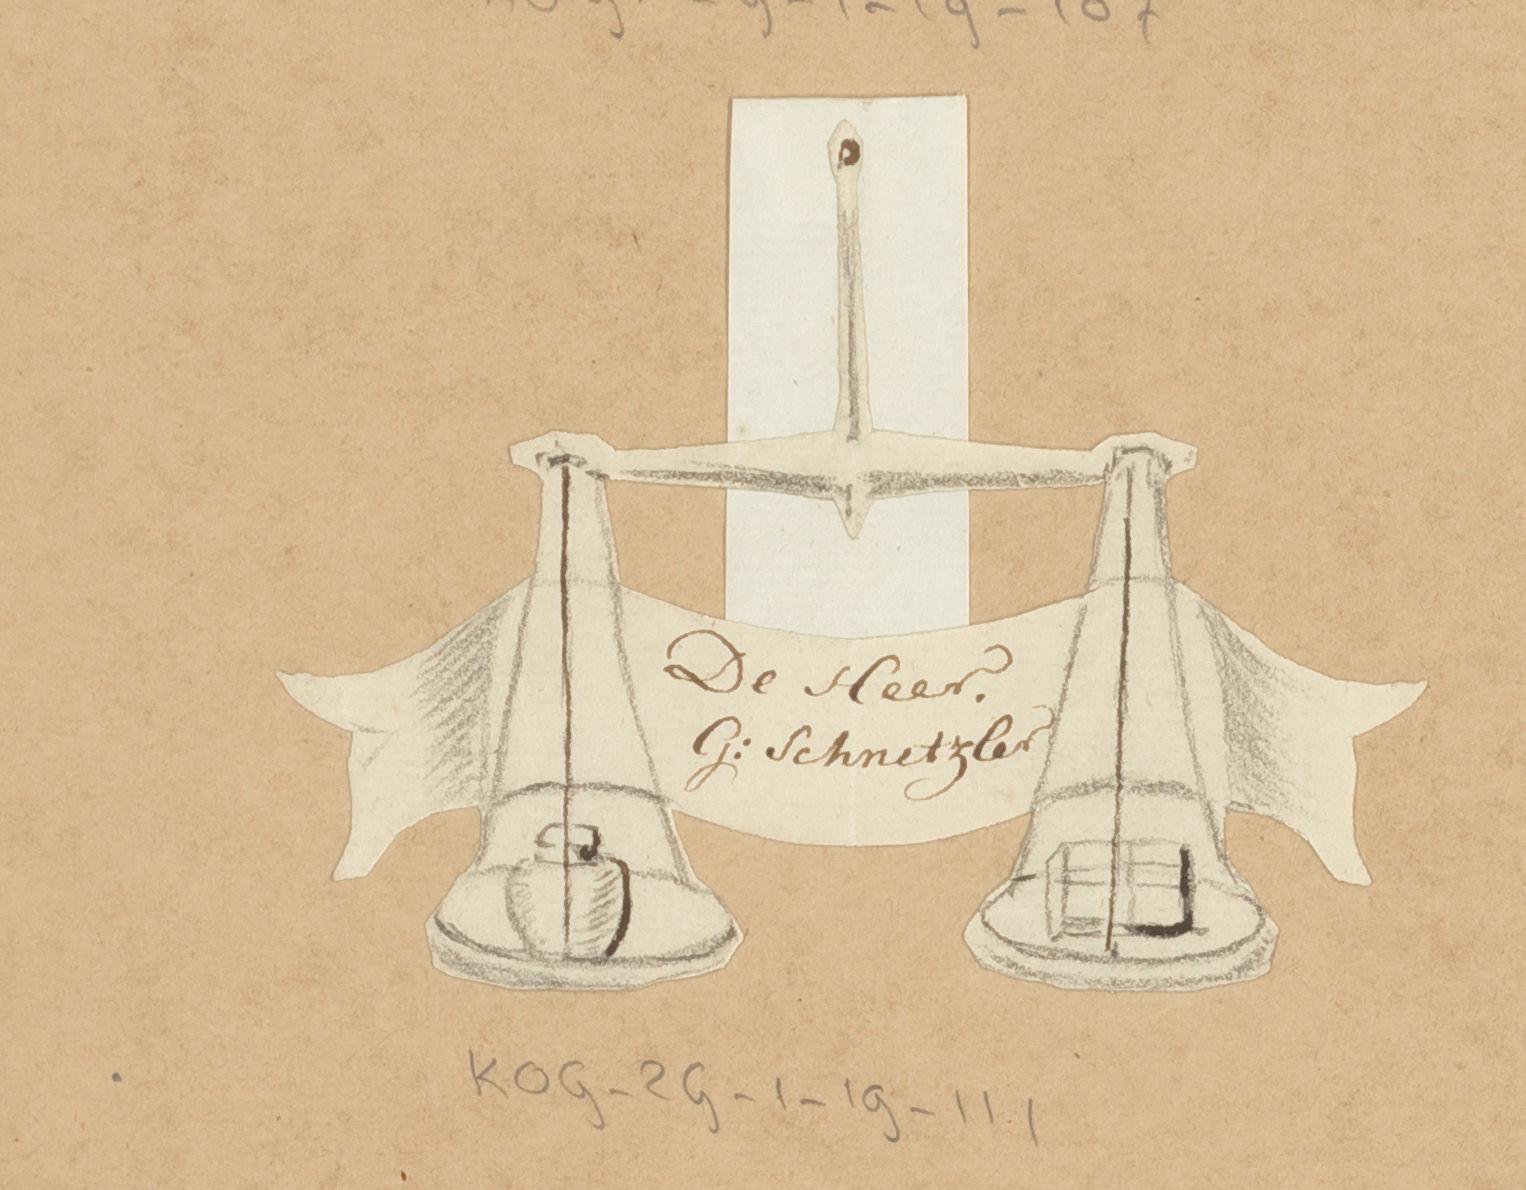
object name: drawing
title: Bruiloftskaart voor 'De Heer G: Schnetzler'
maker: Anonymous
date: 1790-1799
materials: ink, paper, pencil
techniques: pen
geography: netherlands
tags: wedding feast, wedding meal, scales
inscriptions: collector's mark, collector's mark: Lugt 1641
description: Naamkaartje voor de heer G. Schnetzler, in de vorm van een weegschaal, te gebruiken bij de tafelindeling bij een bruiloftsmaal. Waarschijnlijk betreft het hier Gerardus Schnetzler, de broer van Johanna Maria Schnetzler, de vrouw van Jean Bernard. Onderdeel van een groep van bruilofts- en invitatiekaartjes van de families Bernard en Metayer. Onderwerpsrubrieken binnen de Atlas Zeden en Gewoonten: Des Menschen Begin, Midden en Einde. Bruiloft en huwelijk.